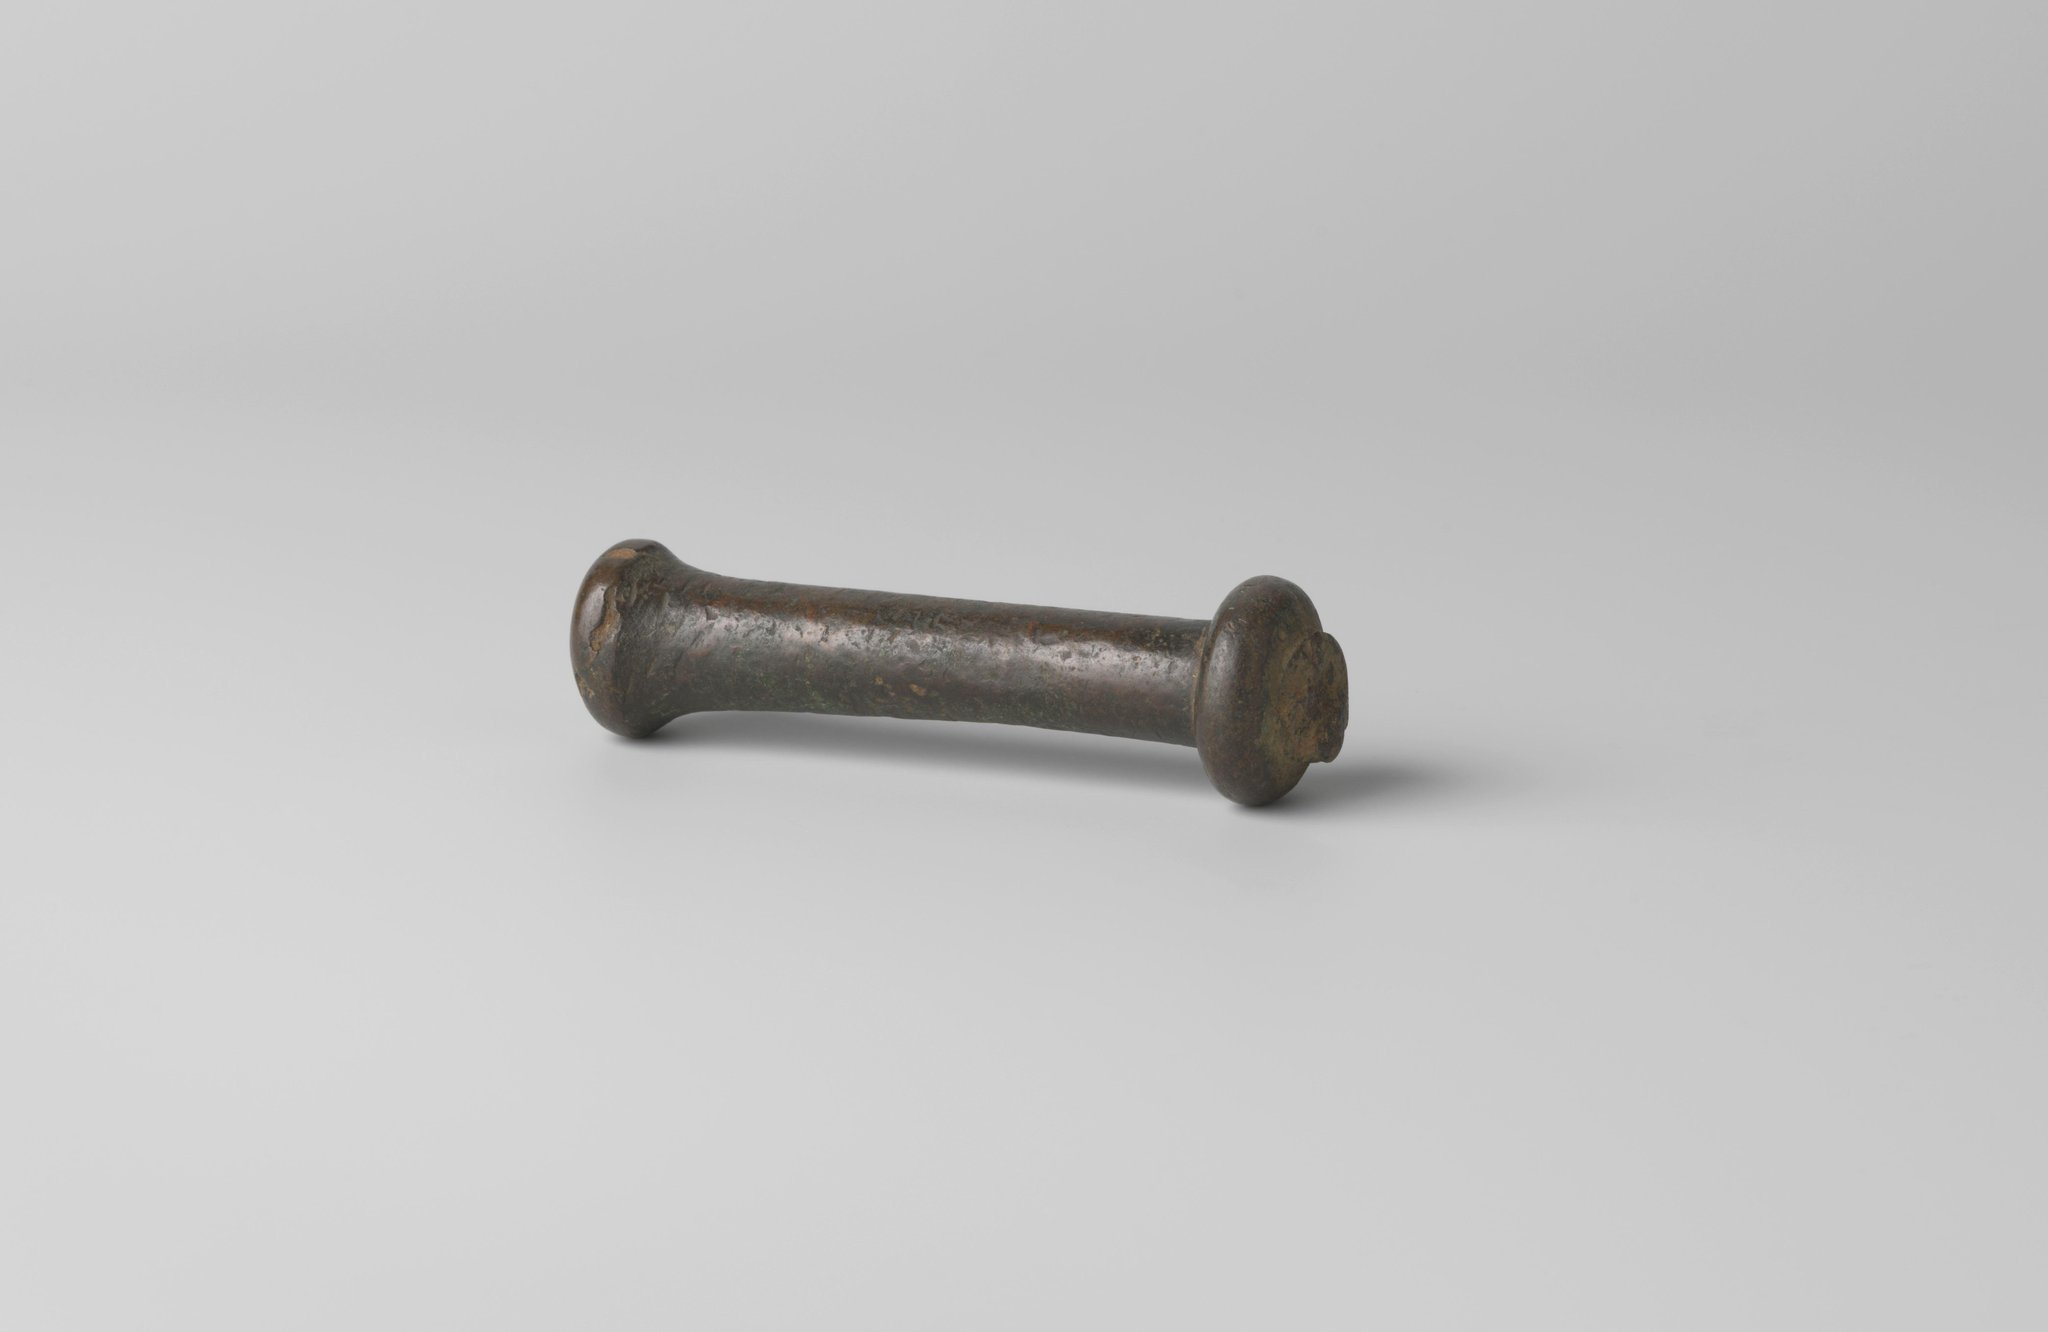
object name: beater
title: Stamper van brons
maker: Anonymous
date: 1600-1699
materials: bronze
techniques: casting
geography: spain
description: Mortar and pestle. Bronze. France or Spain, 17th century (?).